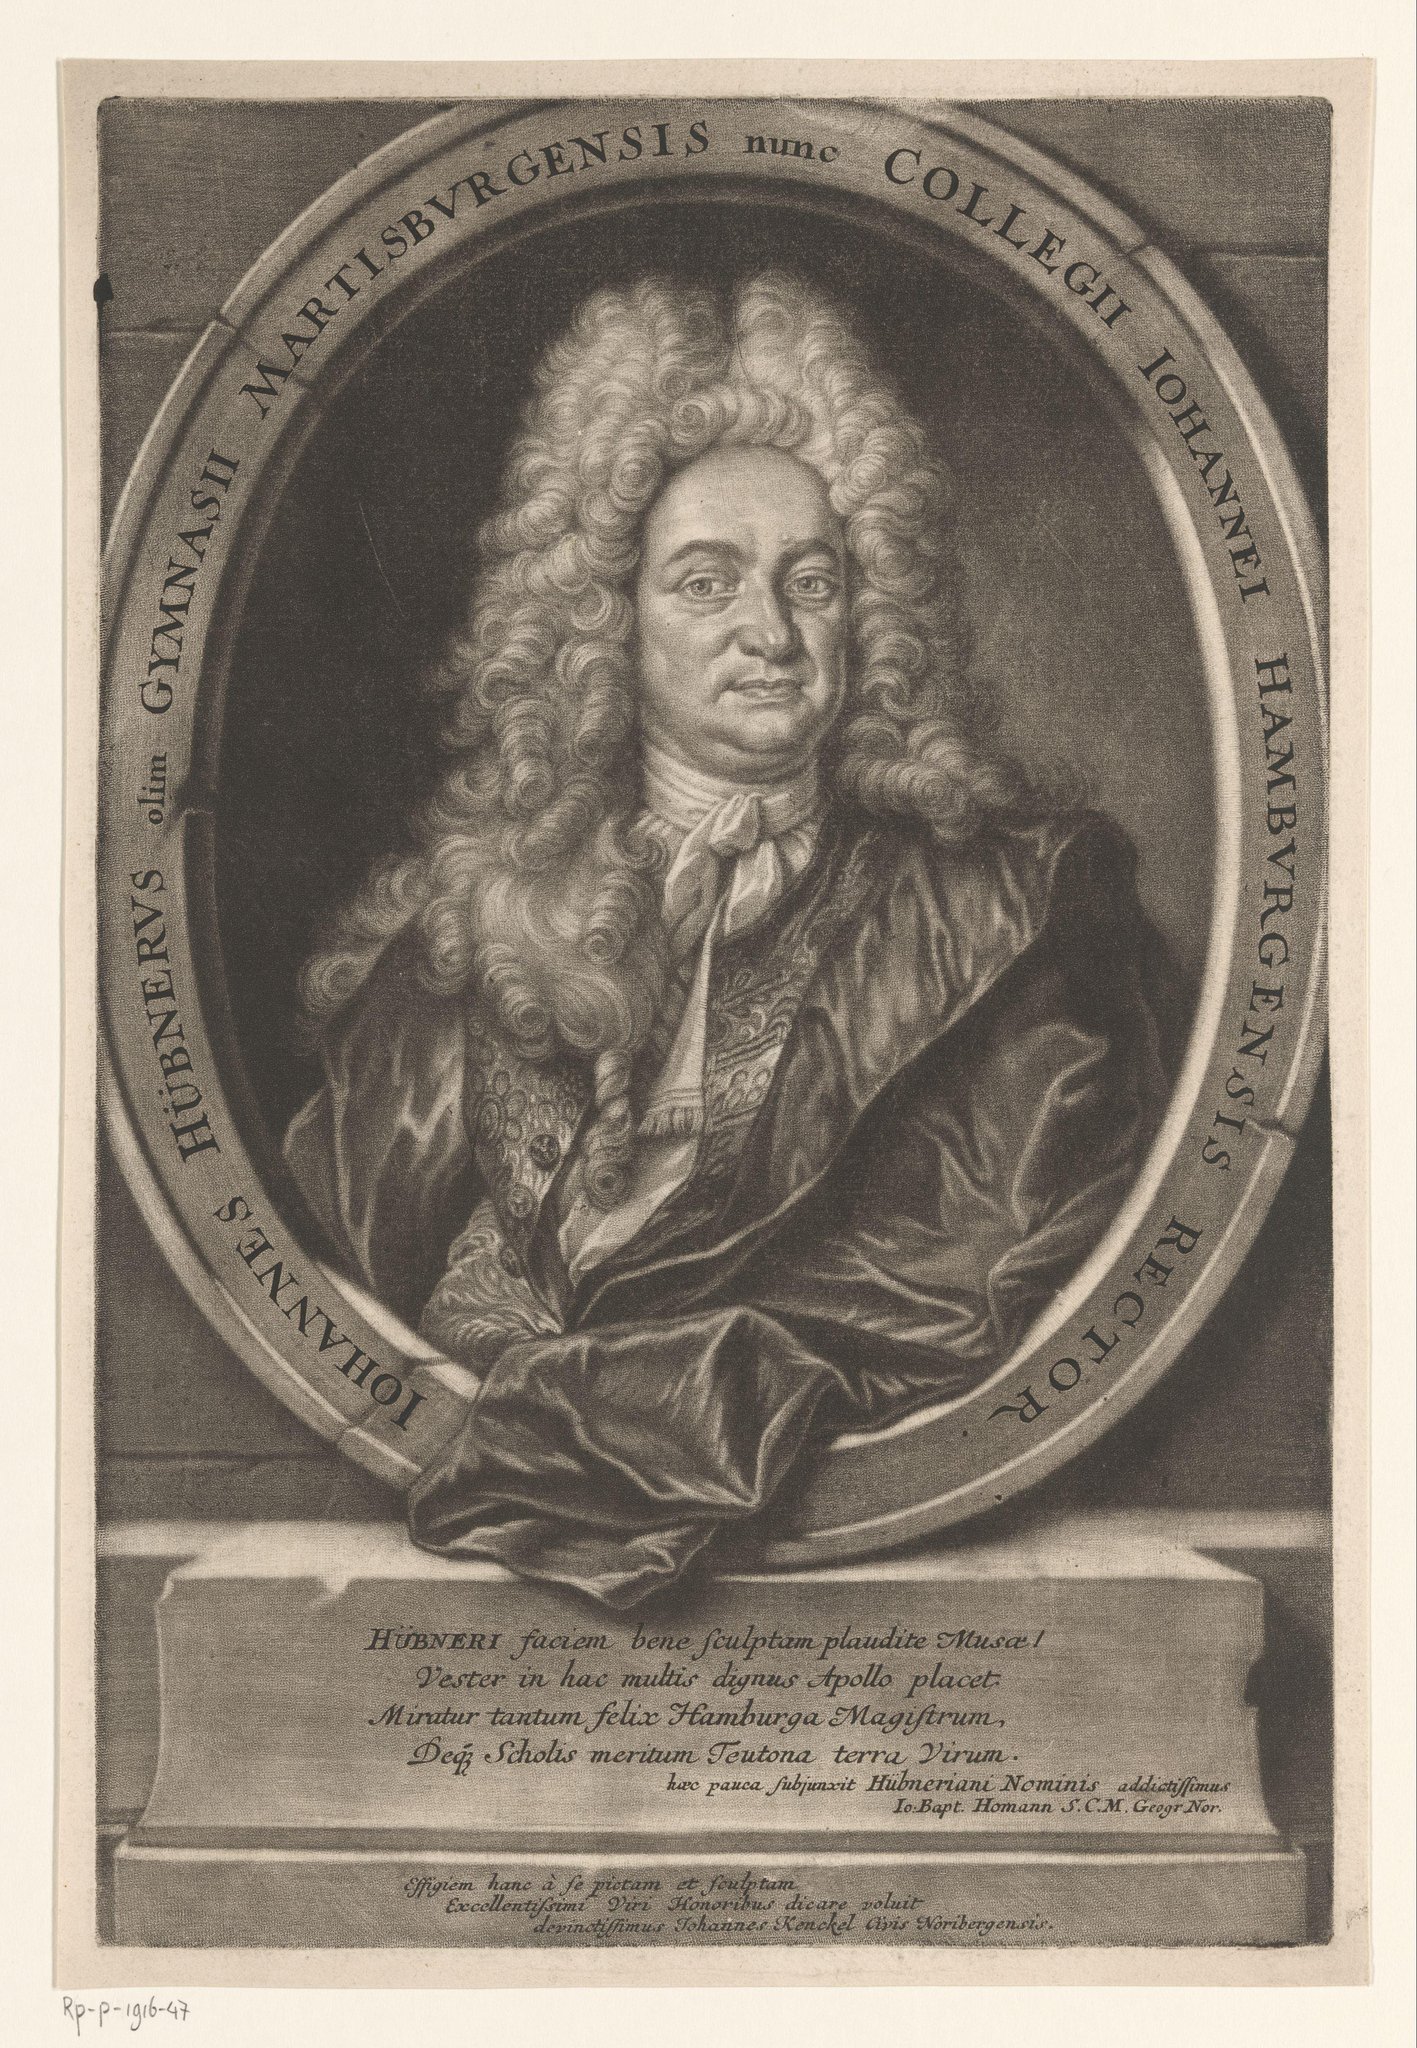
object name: print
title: Portret van Johann Hübner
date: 1698-1722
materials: paper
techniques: mezzotint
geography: nuremberg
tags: publisher, johann hübner, historical persons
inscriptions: collector's mark: Lugt 2228